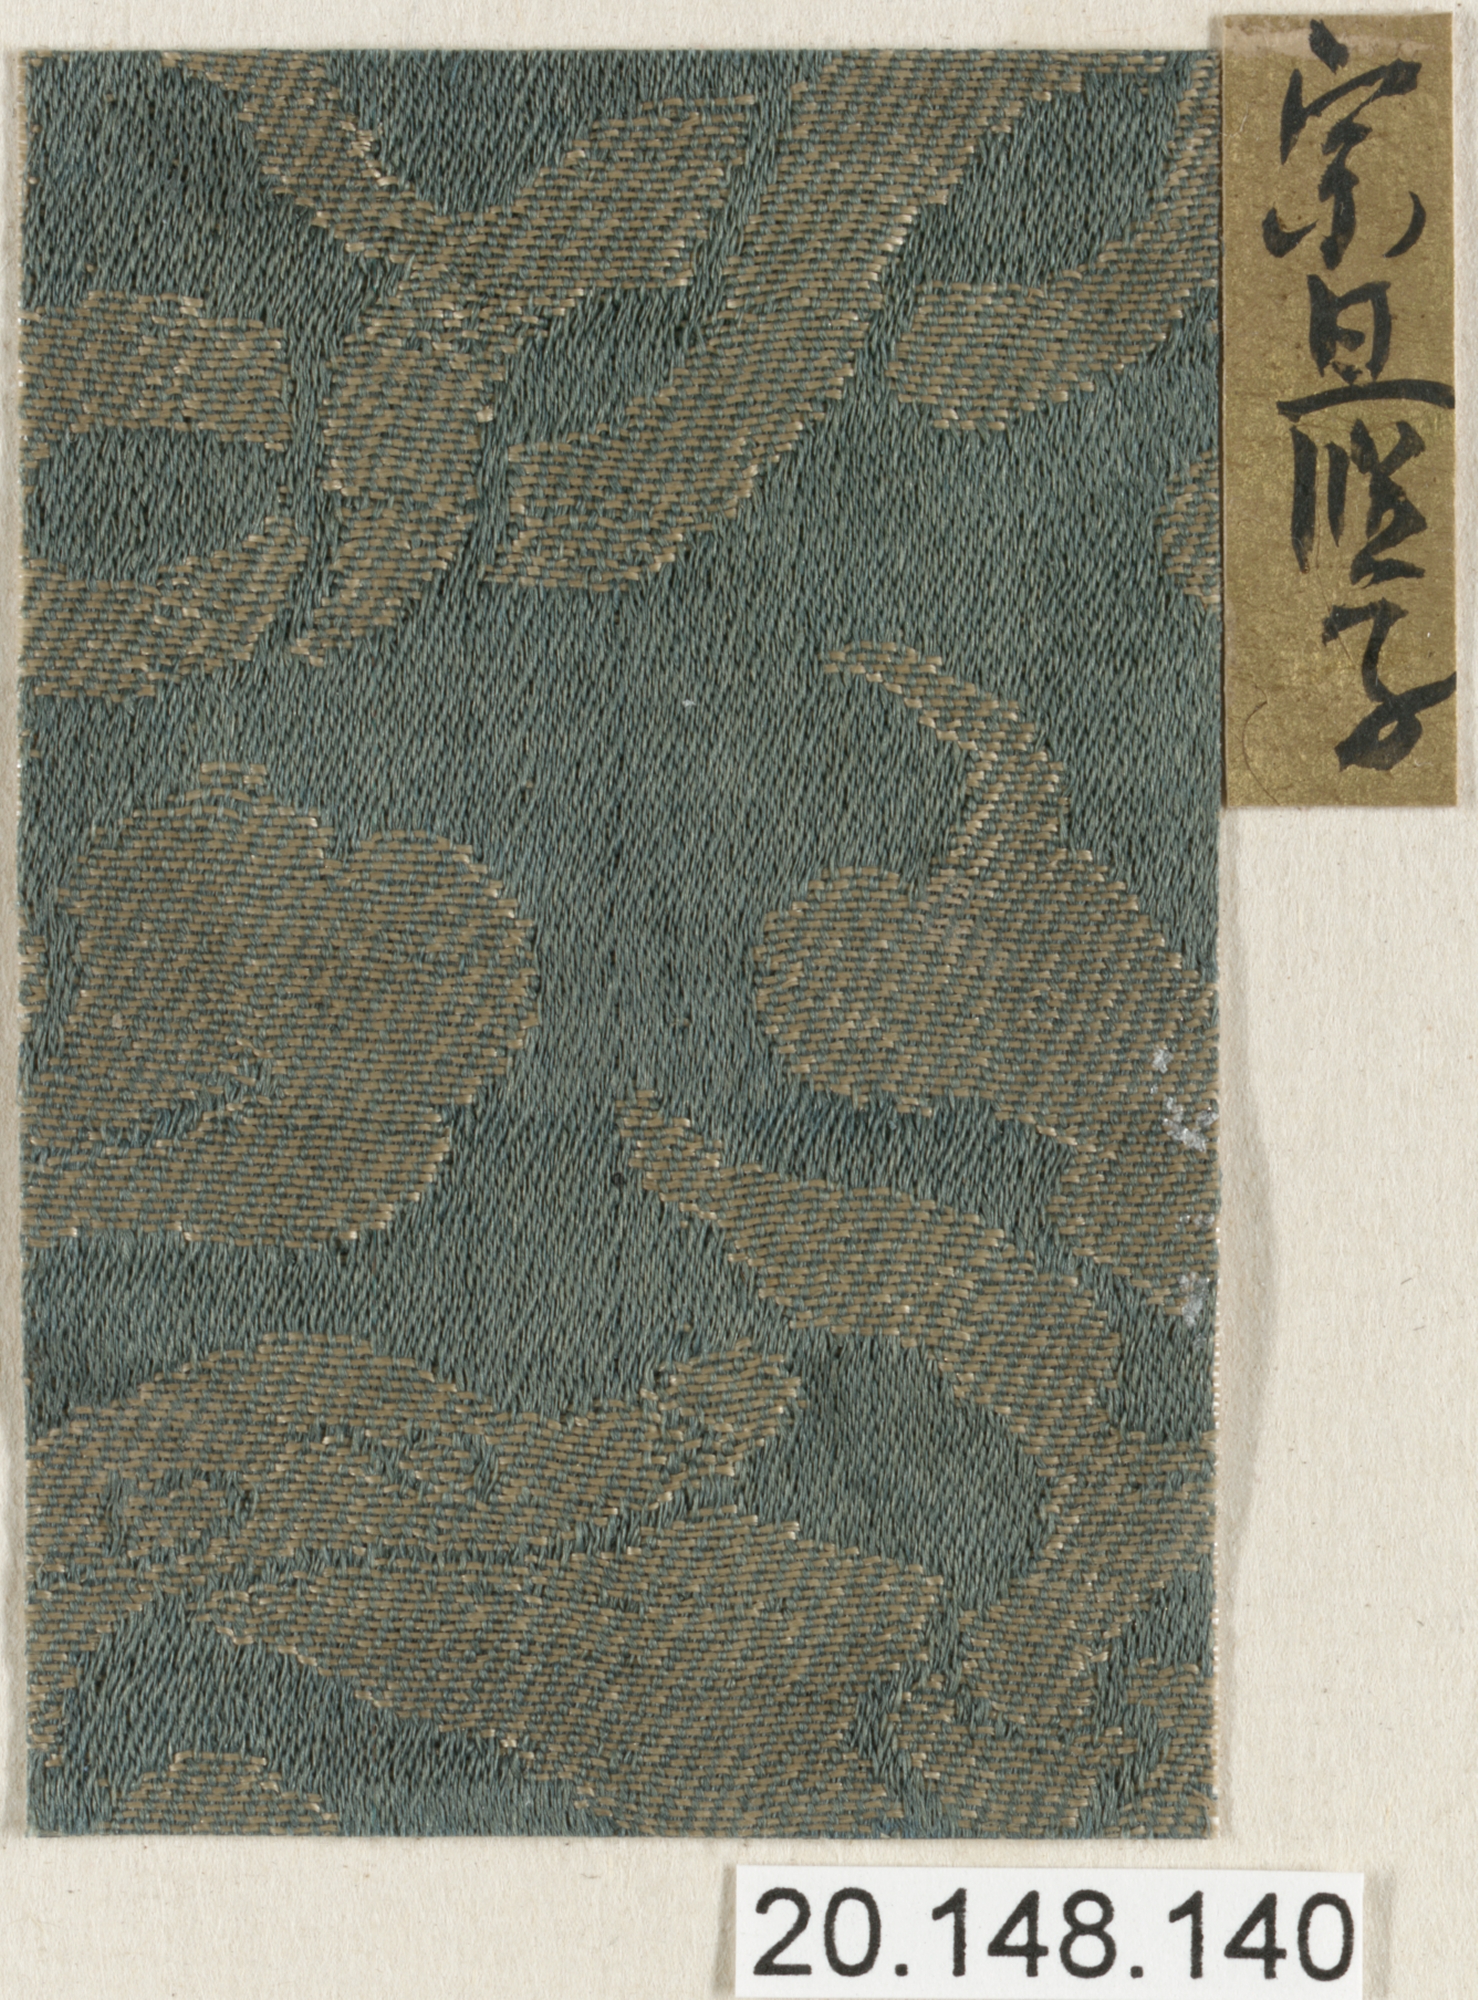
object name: piece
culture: japanese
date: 1601-1700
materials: silk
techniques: compound weave